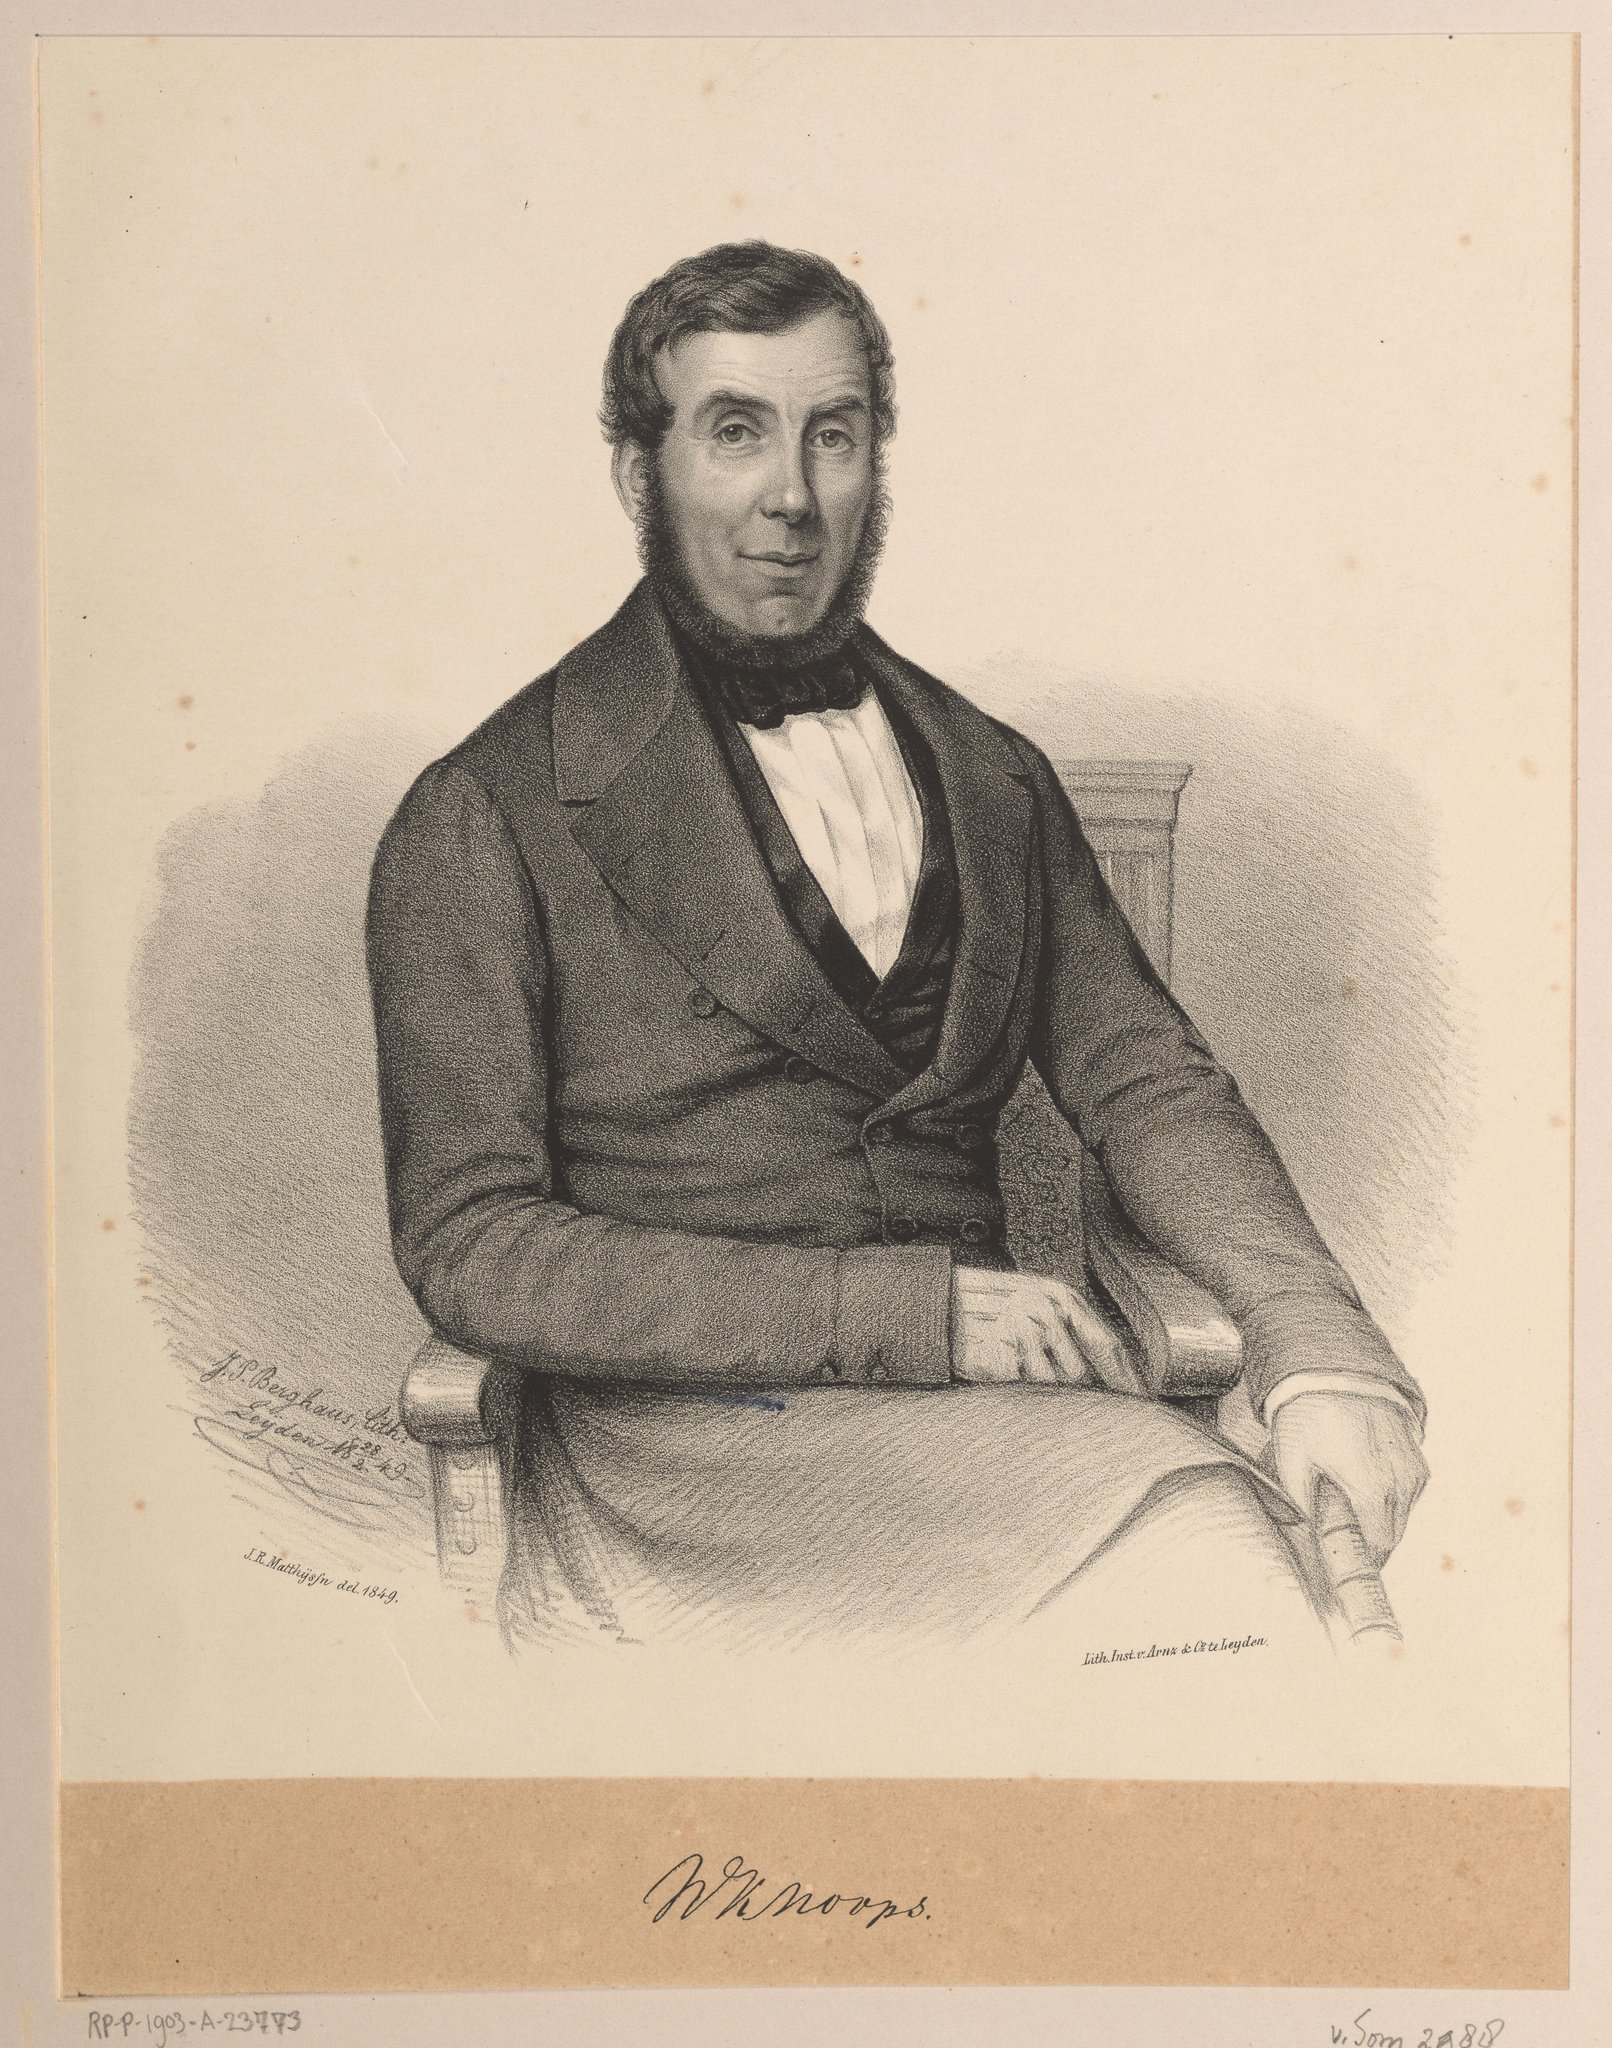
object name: print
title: Portret van Wessel Knoops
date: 1849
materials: paper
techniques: lithograph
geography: leiden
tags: historical persons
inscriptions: collector's mark: Lugt 2228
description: Onder het portret een facsimile van de handtekening van de geportretteerde.